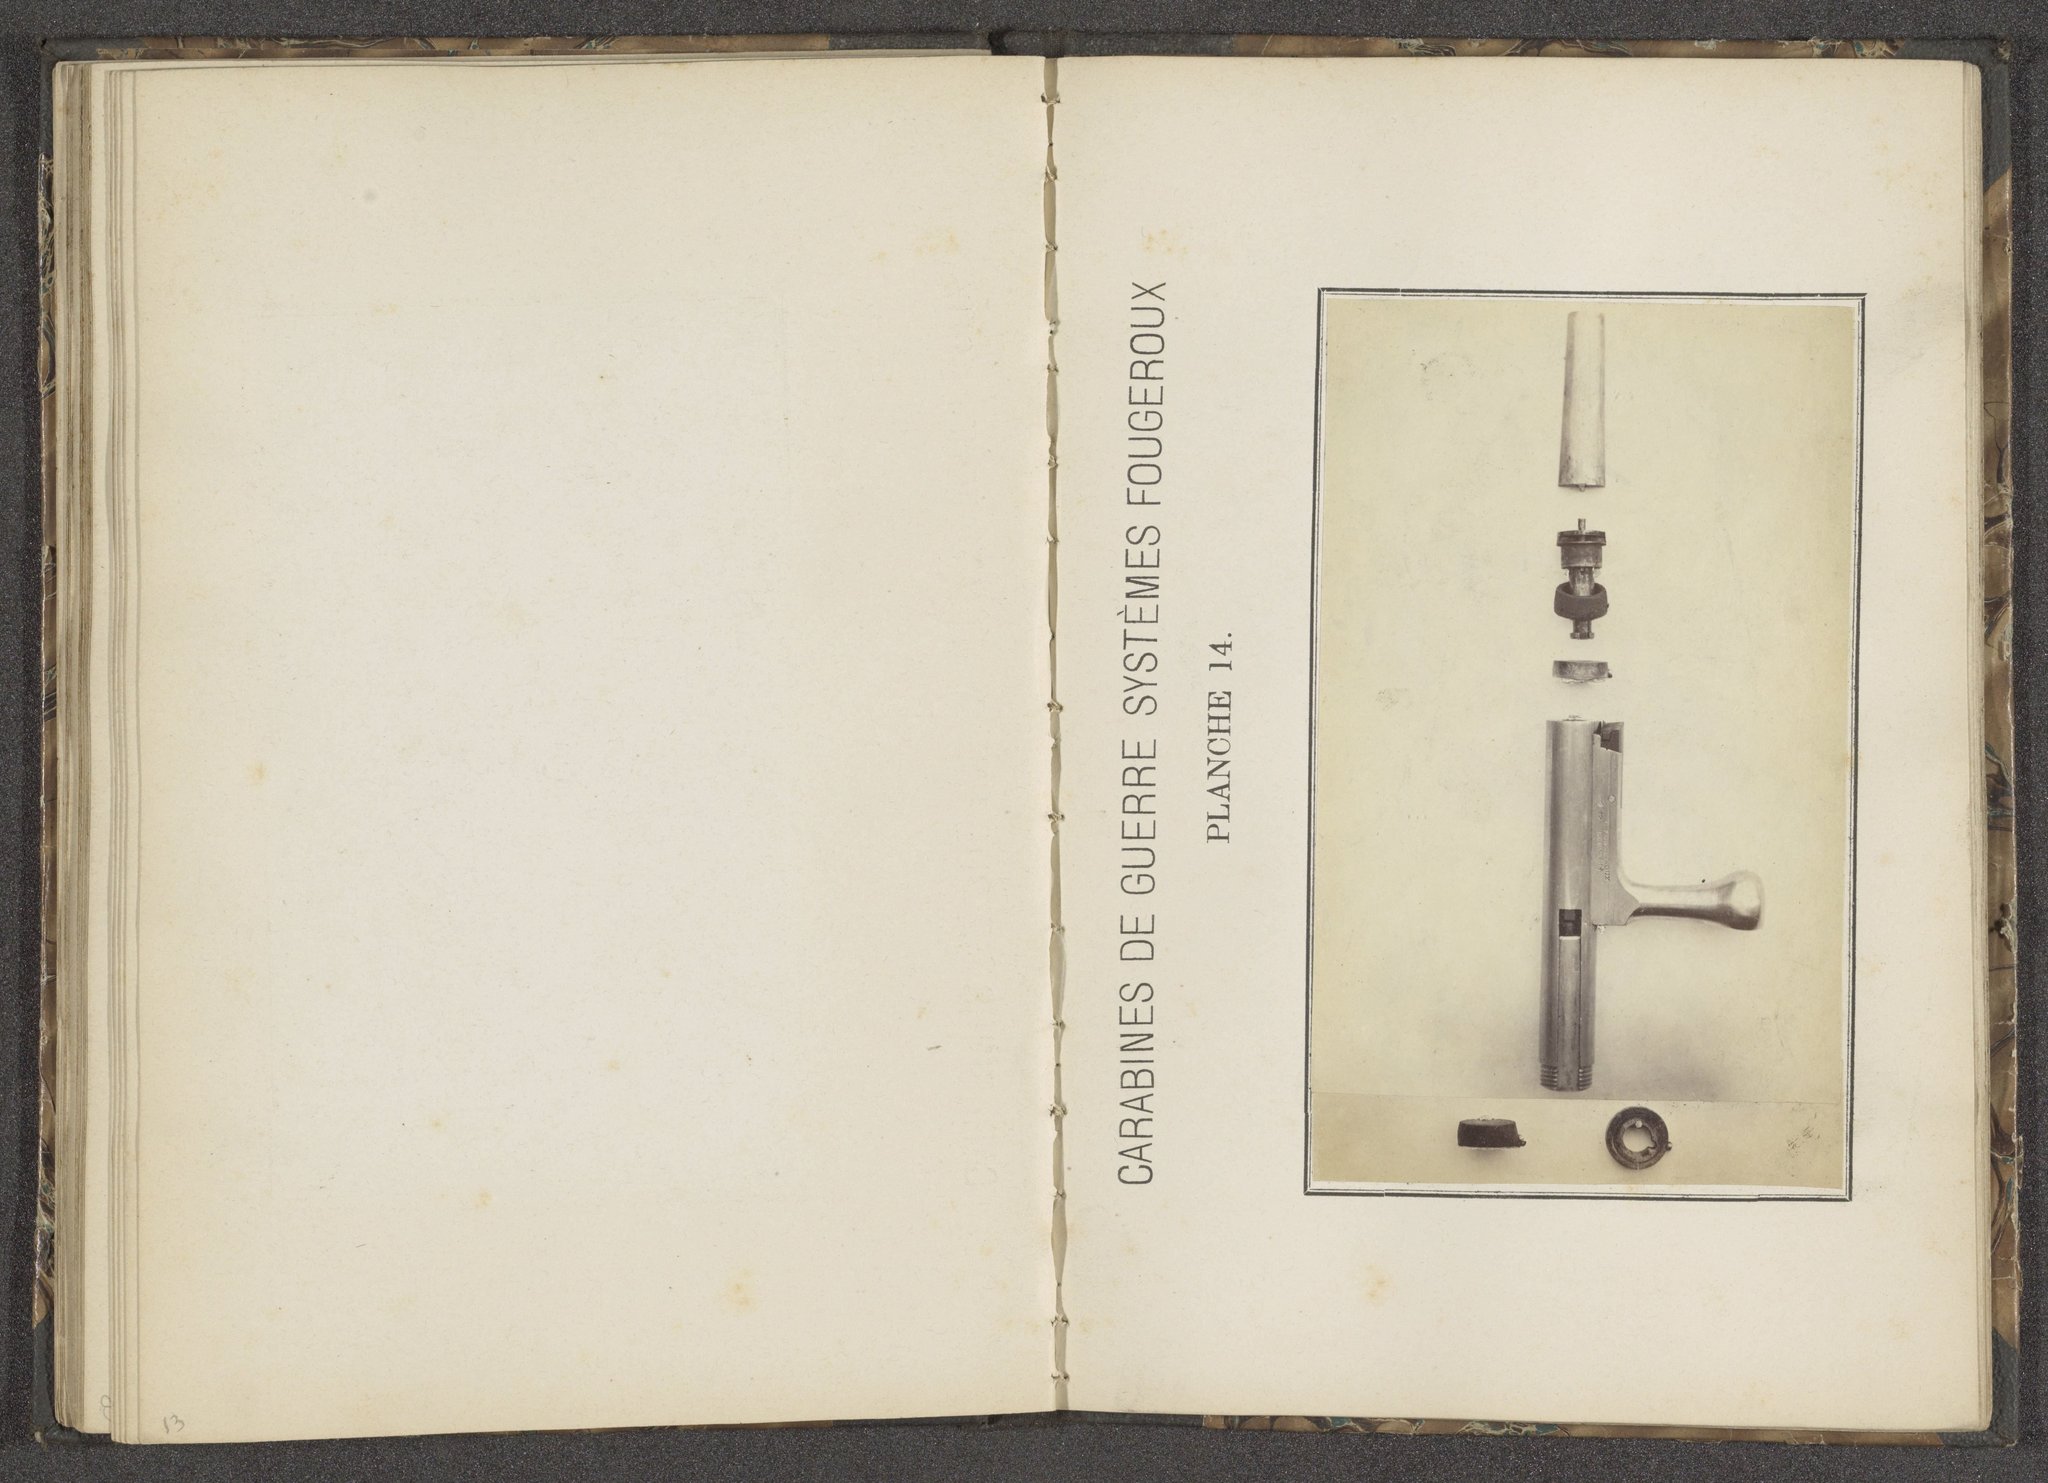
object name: page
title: Veiligheidspal van een geweer in delen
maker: edouard magis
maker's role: fotograaf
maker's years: 1828-1906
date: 1857-1867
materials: photographic support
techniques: albumen print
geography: liège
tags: firearms: rifle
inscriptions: inscription: ‘Carabines de guerres systèmes Fougeroux’, number: ‘Planche 14.’